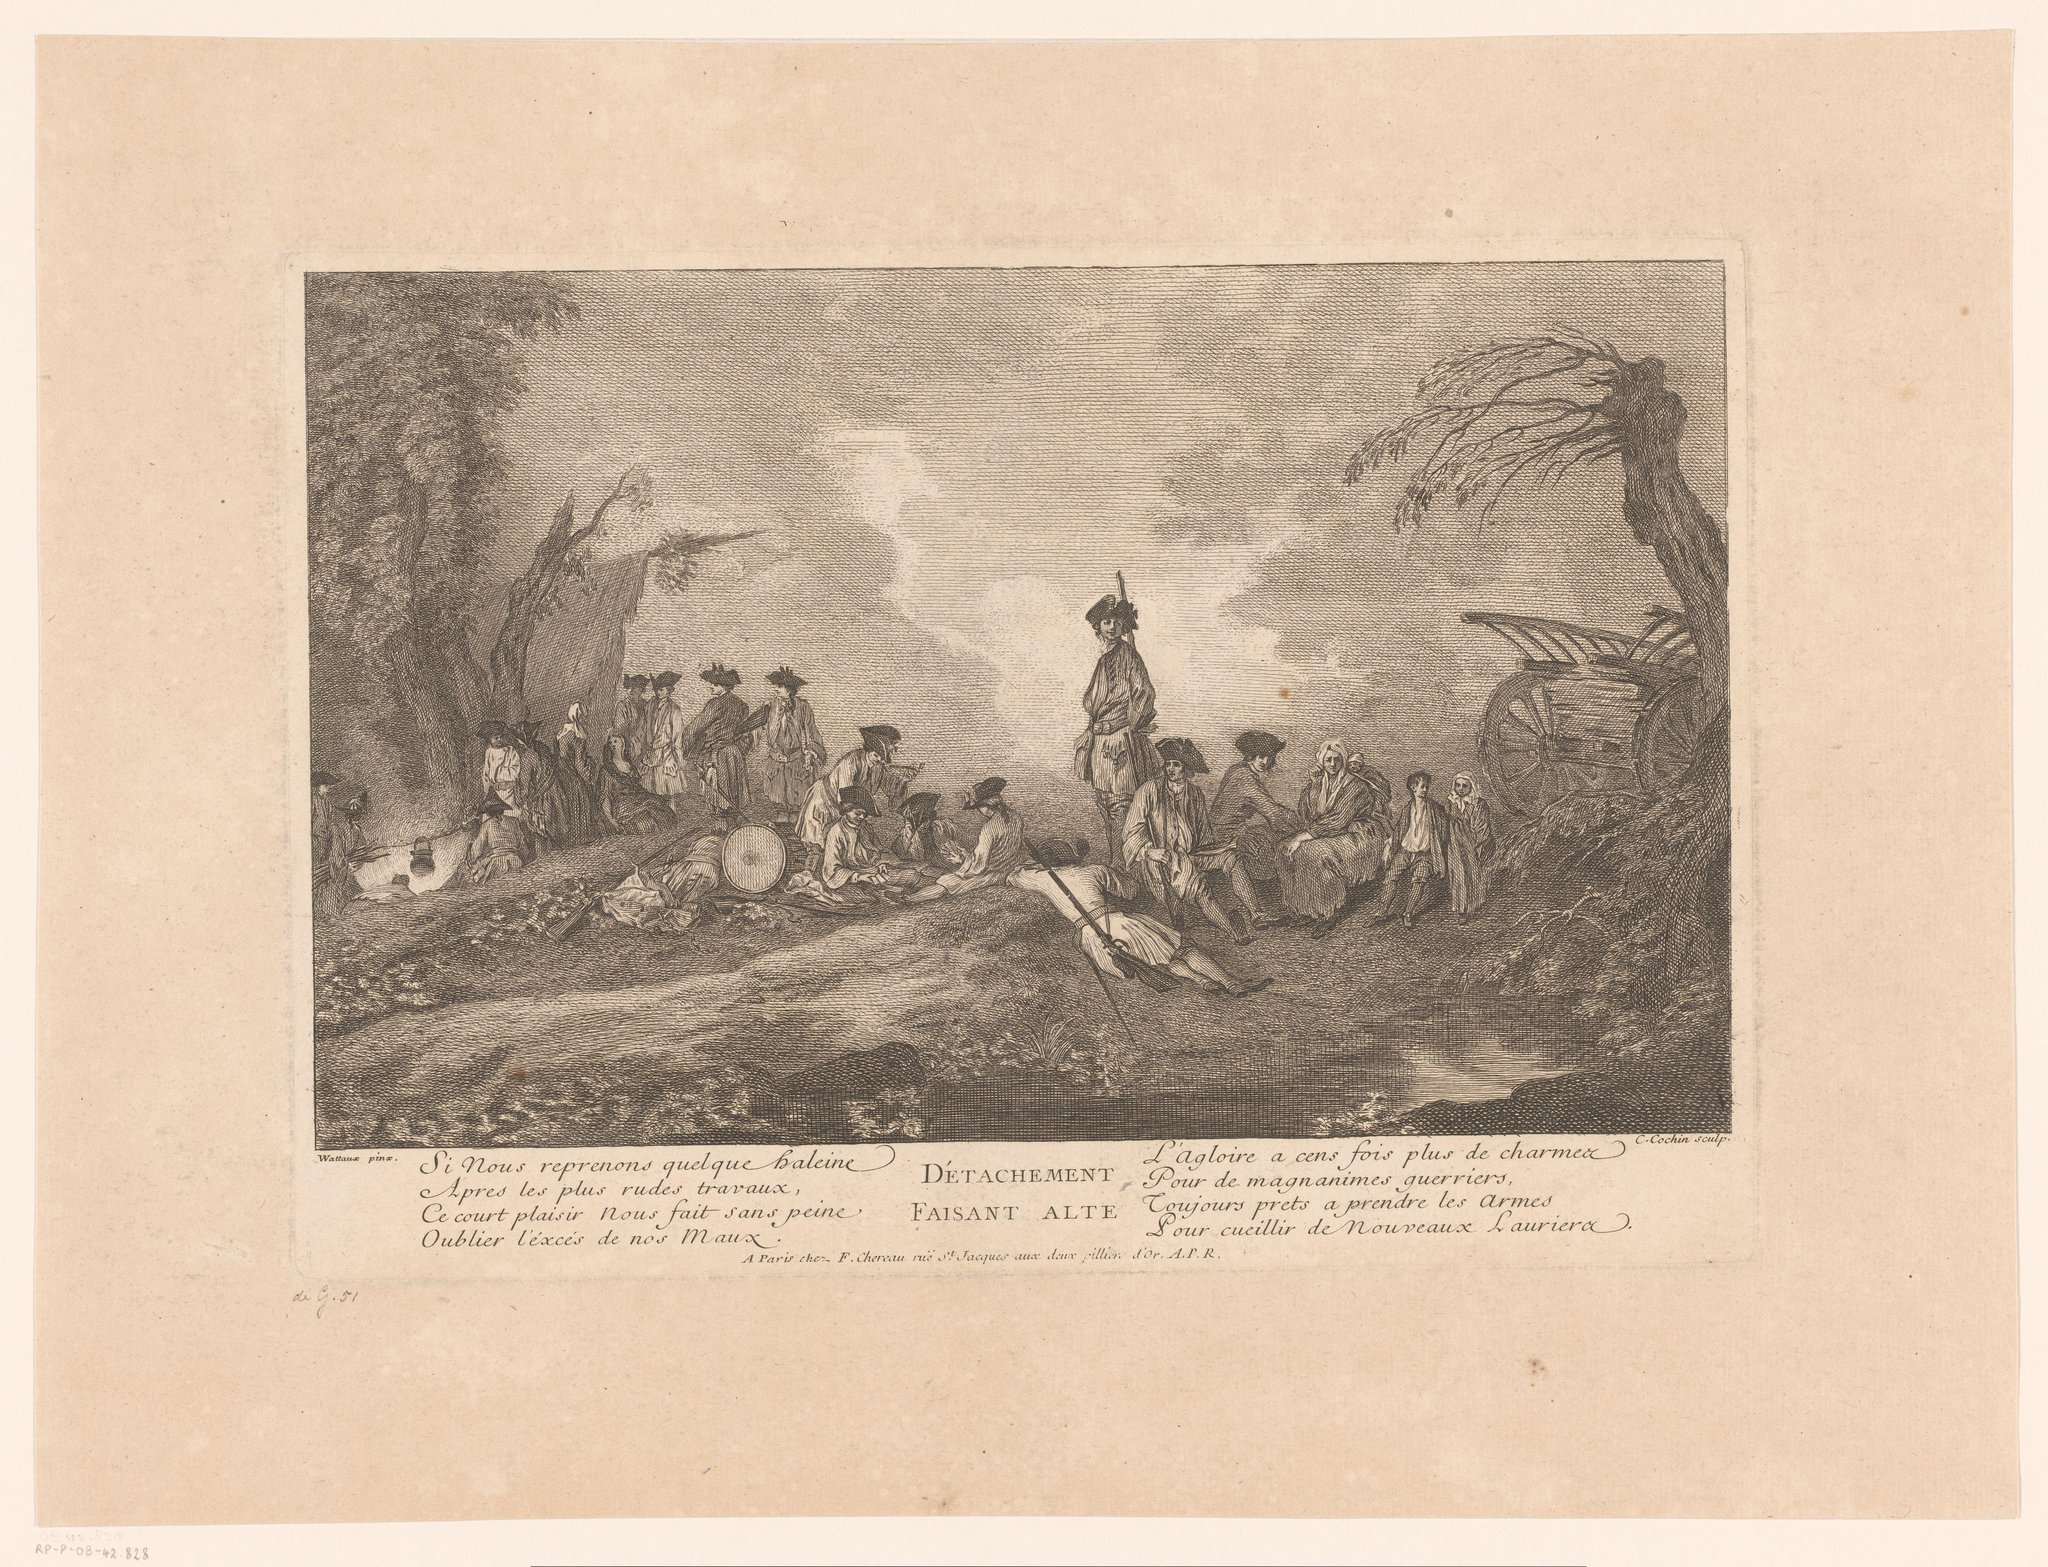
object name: print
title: Soldatenkamp met vrouwen en kinderen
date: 1717-1726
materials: paper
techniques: engraving, etching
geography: france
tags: (military) camp with tents, women camp-followers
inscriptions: collector's mark: Lugt 2228